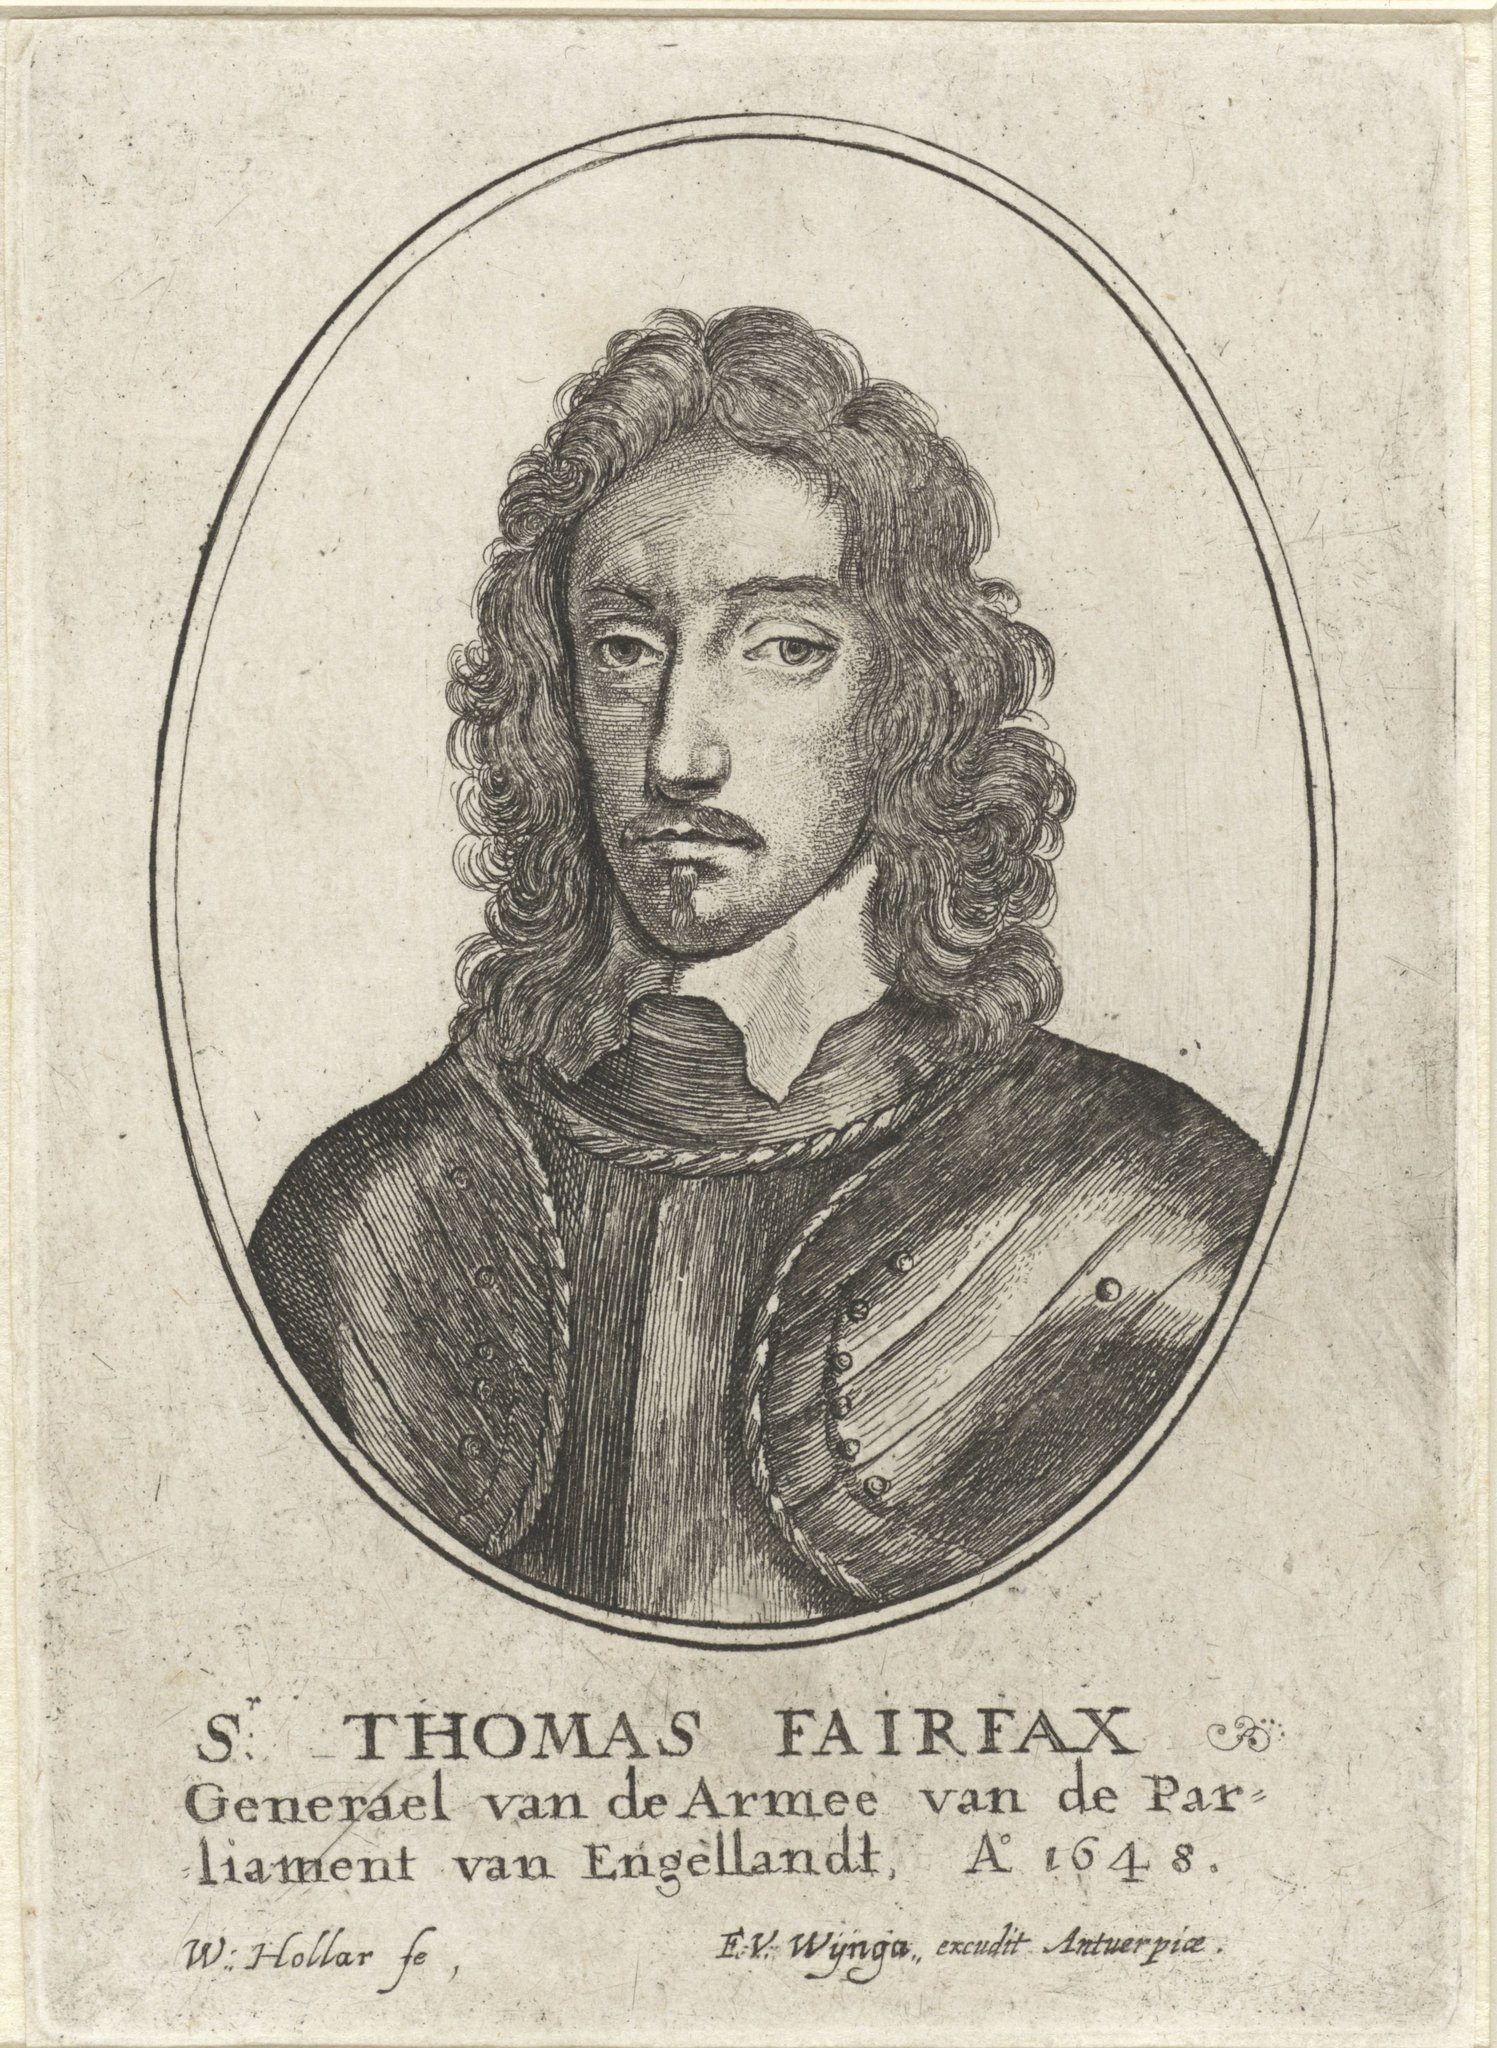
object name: print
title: Portret van Thomas Fairfax, militair leider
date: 1648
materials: paper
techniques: etching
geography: antwerp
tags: denton, nunappleton, militair, thomas fairfax (sir)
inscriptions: date